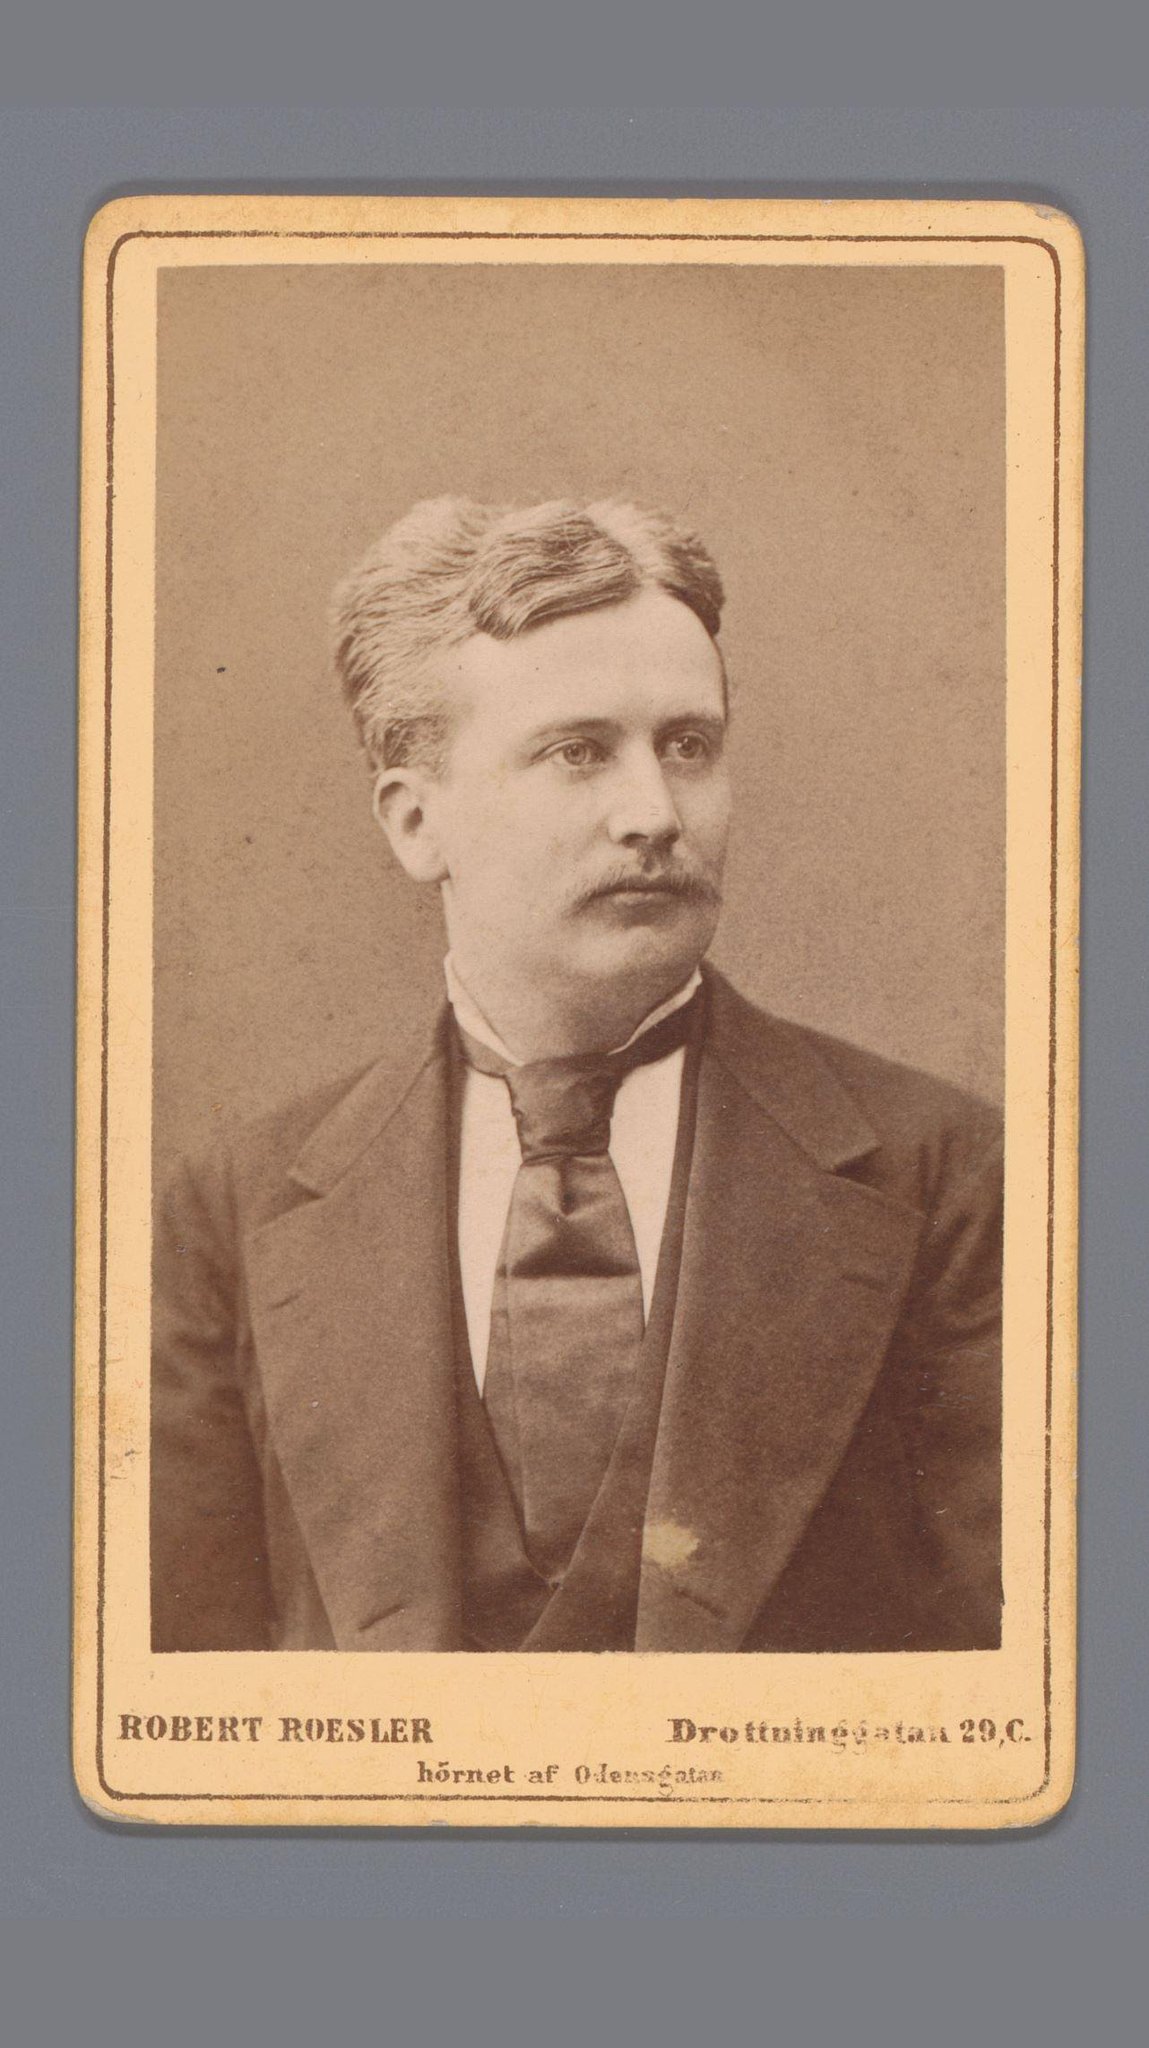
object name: photograph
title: Portret van een onbekende man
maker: august roesler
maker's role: fotograaf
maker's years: 1837-1896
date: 1876-1896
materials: cardboard, paper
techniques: albumen print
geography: stockholm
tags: adult man, historical persons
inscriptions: inscription: ‘1876/ PHILADELPHIA/ ROBERT ROESLER. Stockholm/ 29c. Drottninggatan 29c./ Plåten förvaras för efterbeställning./ O.b.s./hörnet af Odensgaten’